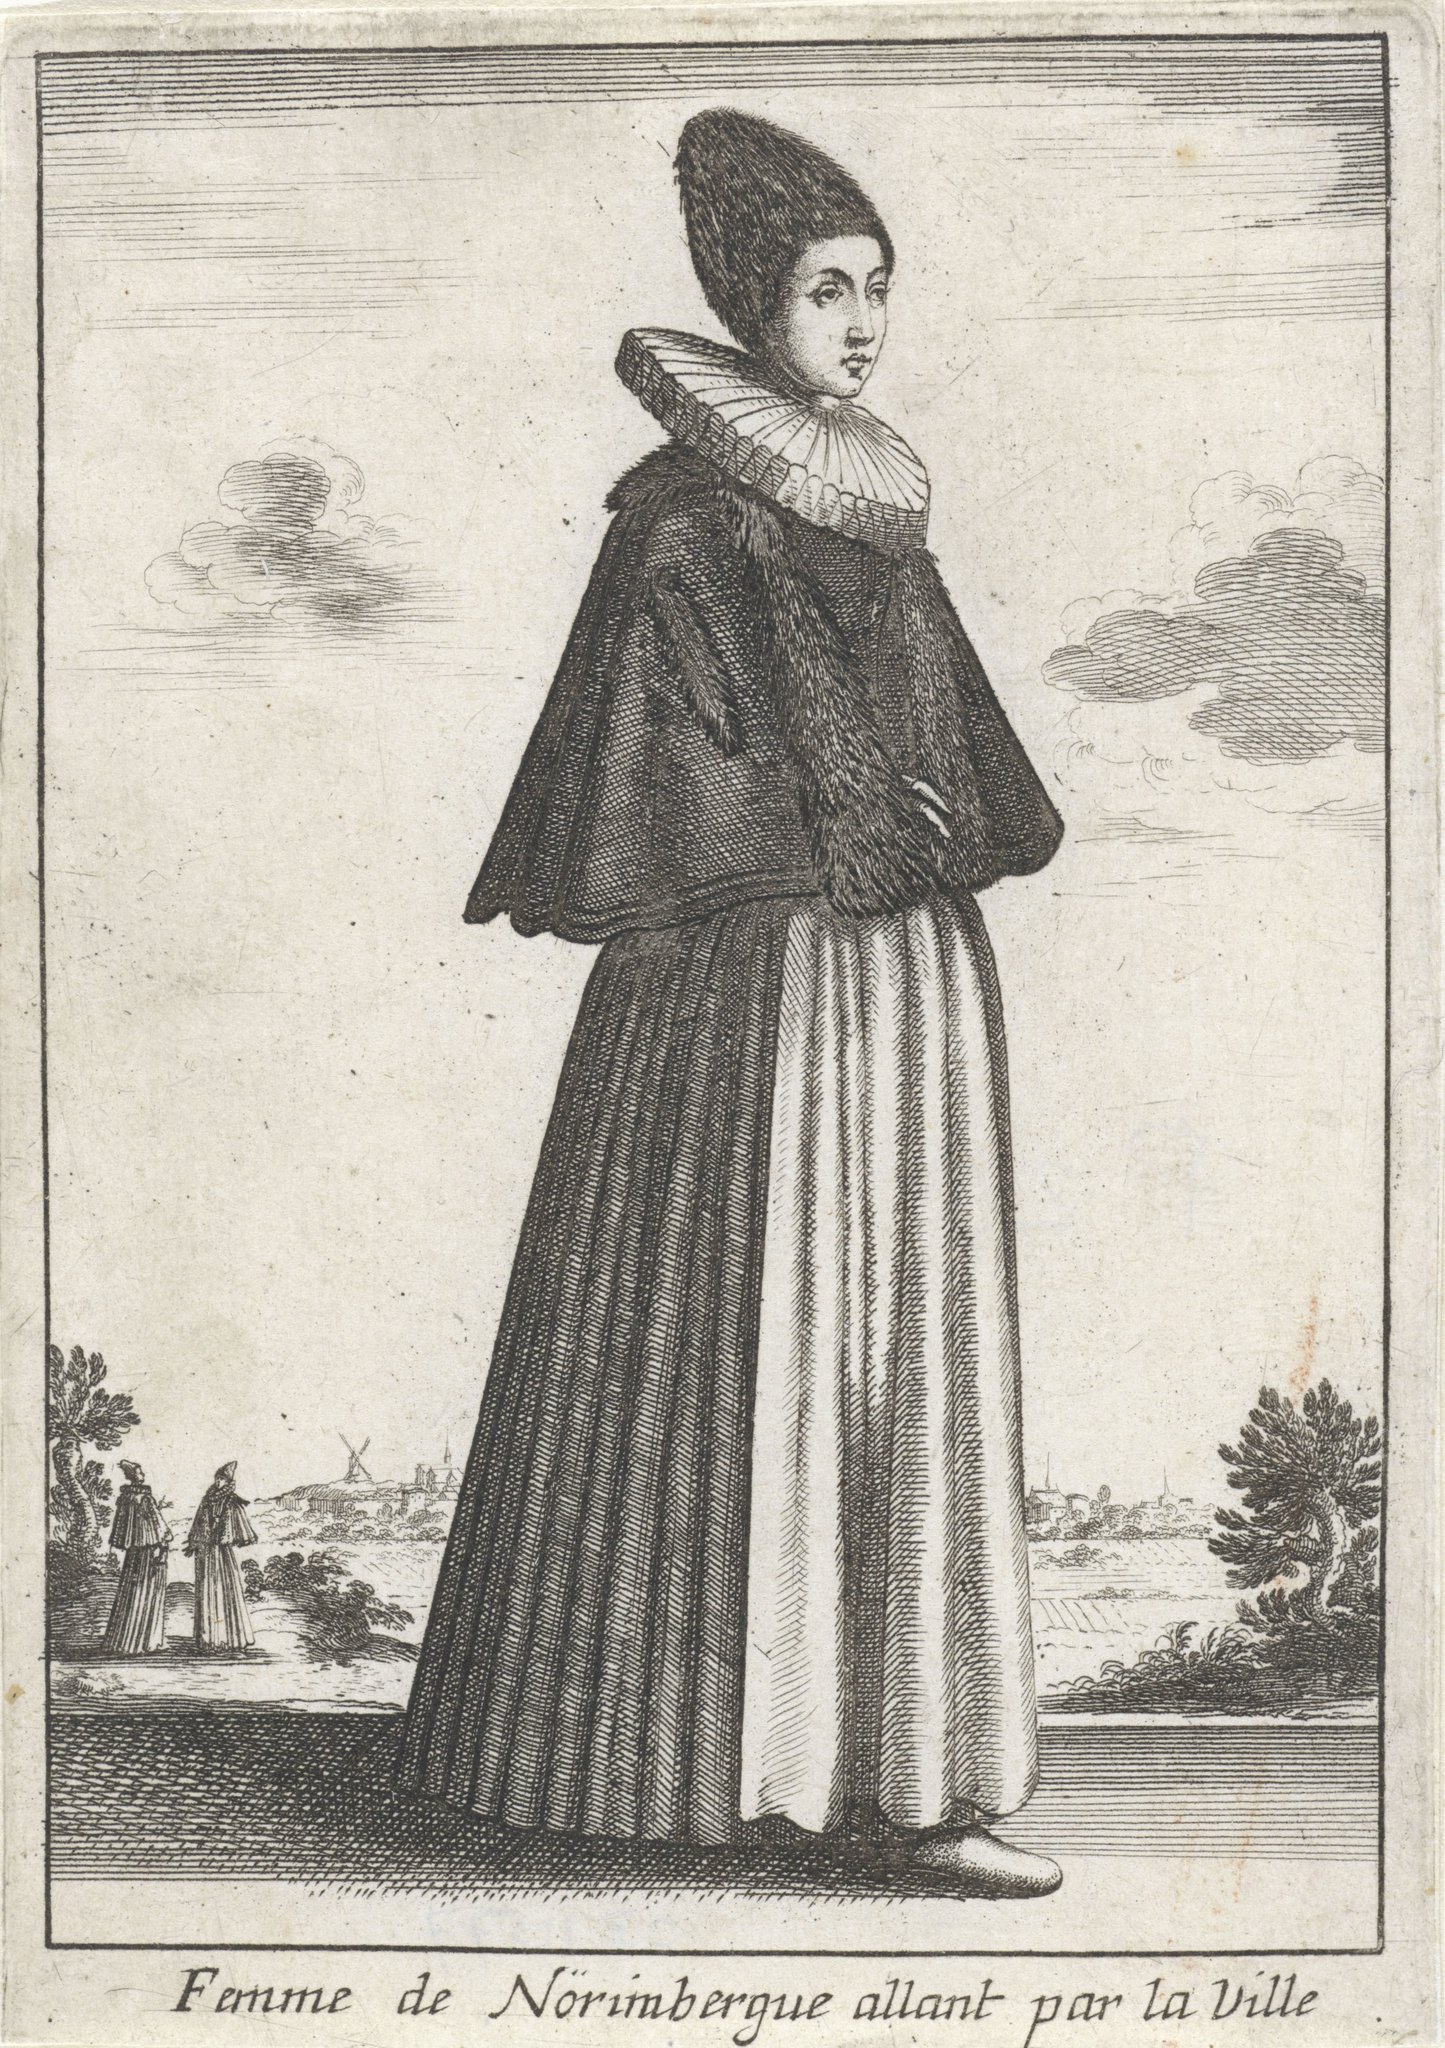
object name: costume print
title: Femme de Nörimbergue allant par la Ville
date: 1662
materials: paper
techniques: etching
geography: paris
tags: neurenberg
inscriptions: collector's mark: Lugt 240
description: Kopie naar prent die deel uitmaakt van de 50-delige serie met Europese klederdrachten, getiteld "Aula Veneris".. De prent maakt deel uit van de 28-delige serie (excl. titelprent) met voorstellingen van vrouwen in verschillende klederdrachten, getiteld "Livre curieux contenant la naifue representations des habits des femmes des diverses parties du Monde (...), 1662".